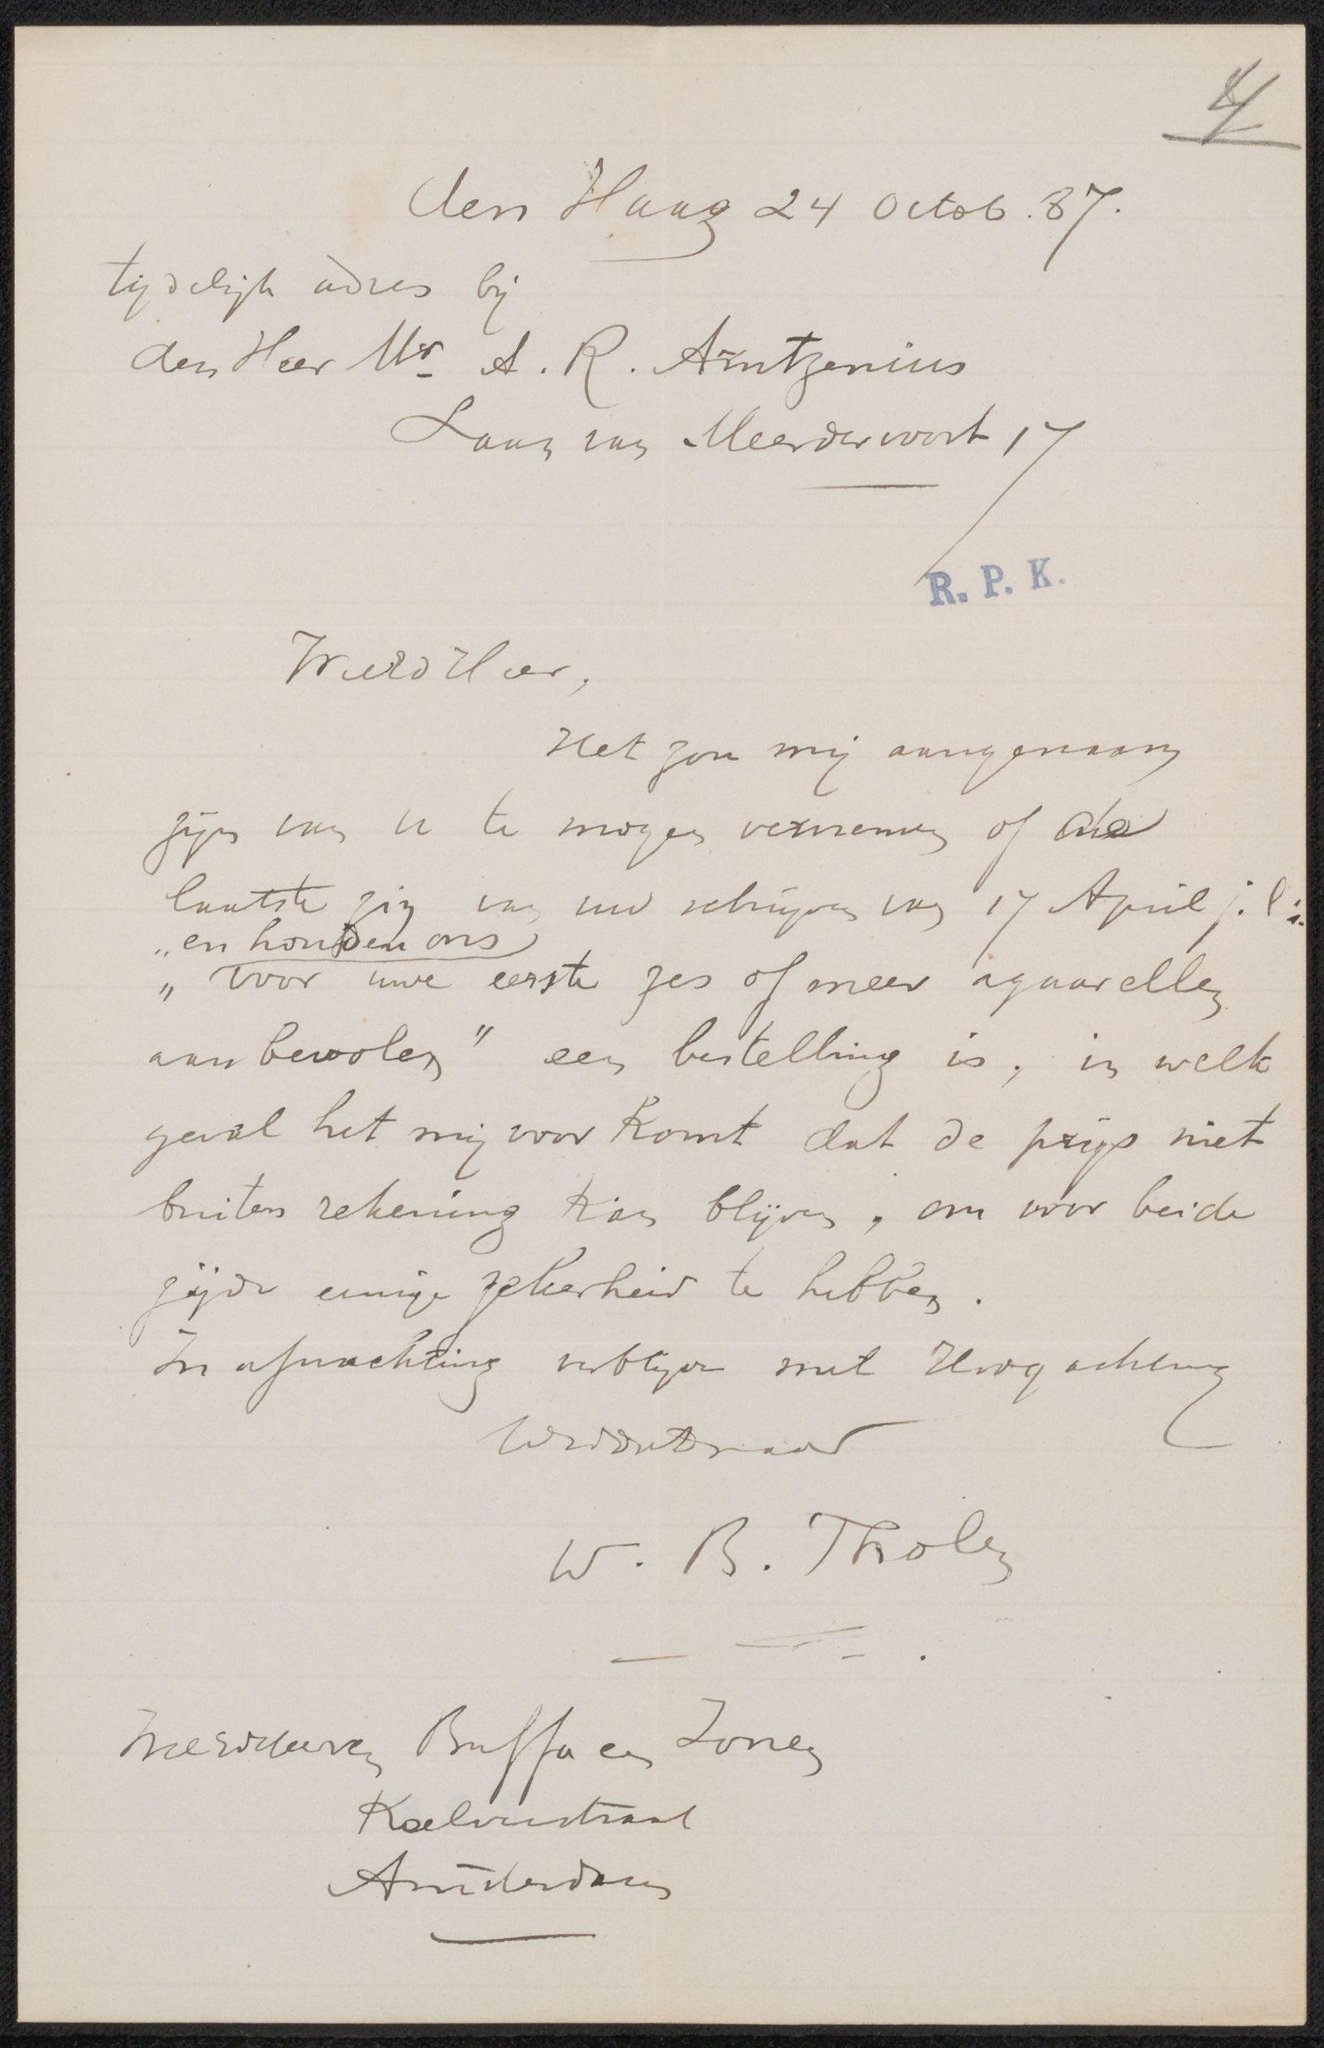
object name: letter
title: Brief aan Frans Buffa en Zonen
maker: willem bastiaan tholen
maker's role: draughtsman, painter, print maker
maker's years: 1860-1931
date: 1887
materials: ink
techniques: pen, writing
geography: the hague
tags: publisher, art trade, art shop, drawing, money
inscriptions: collector's mark: Lugt 2233